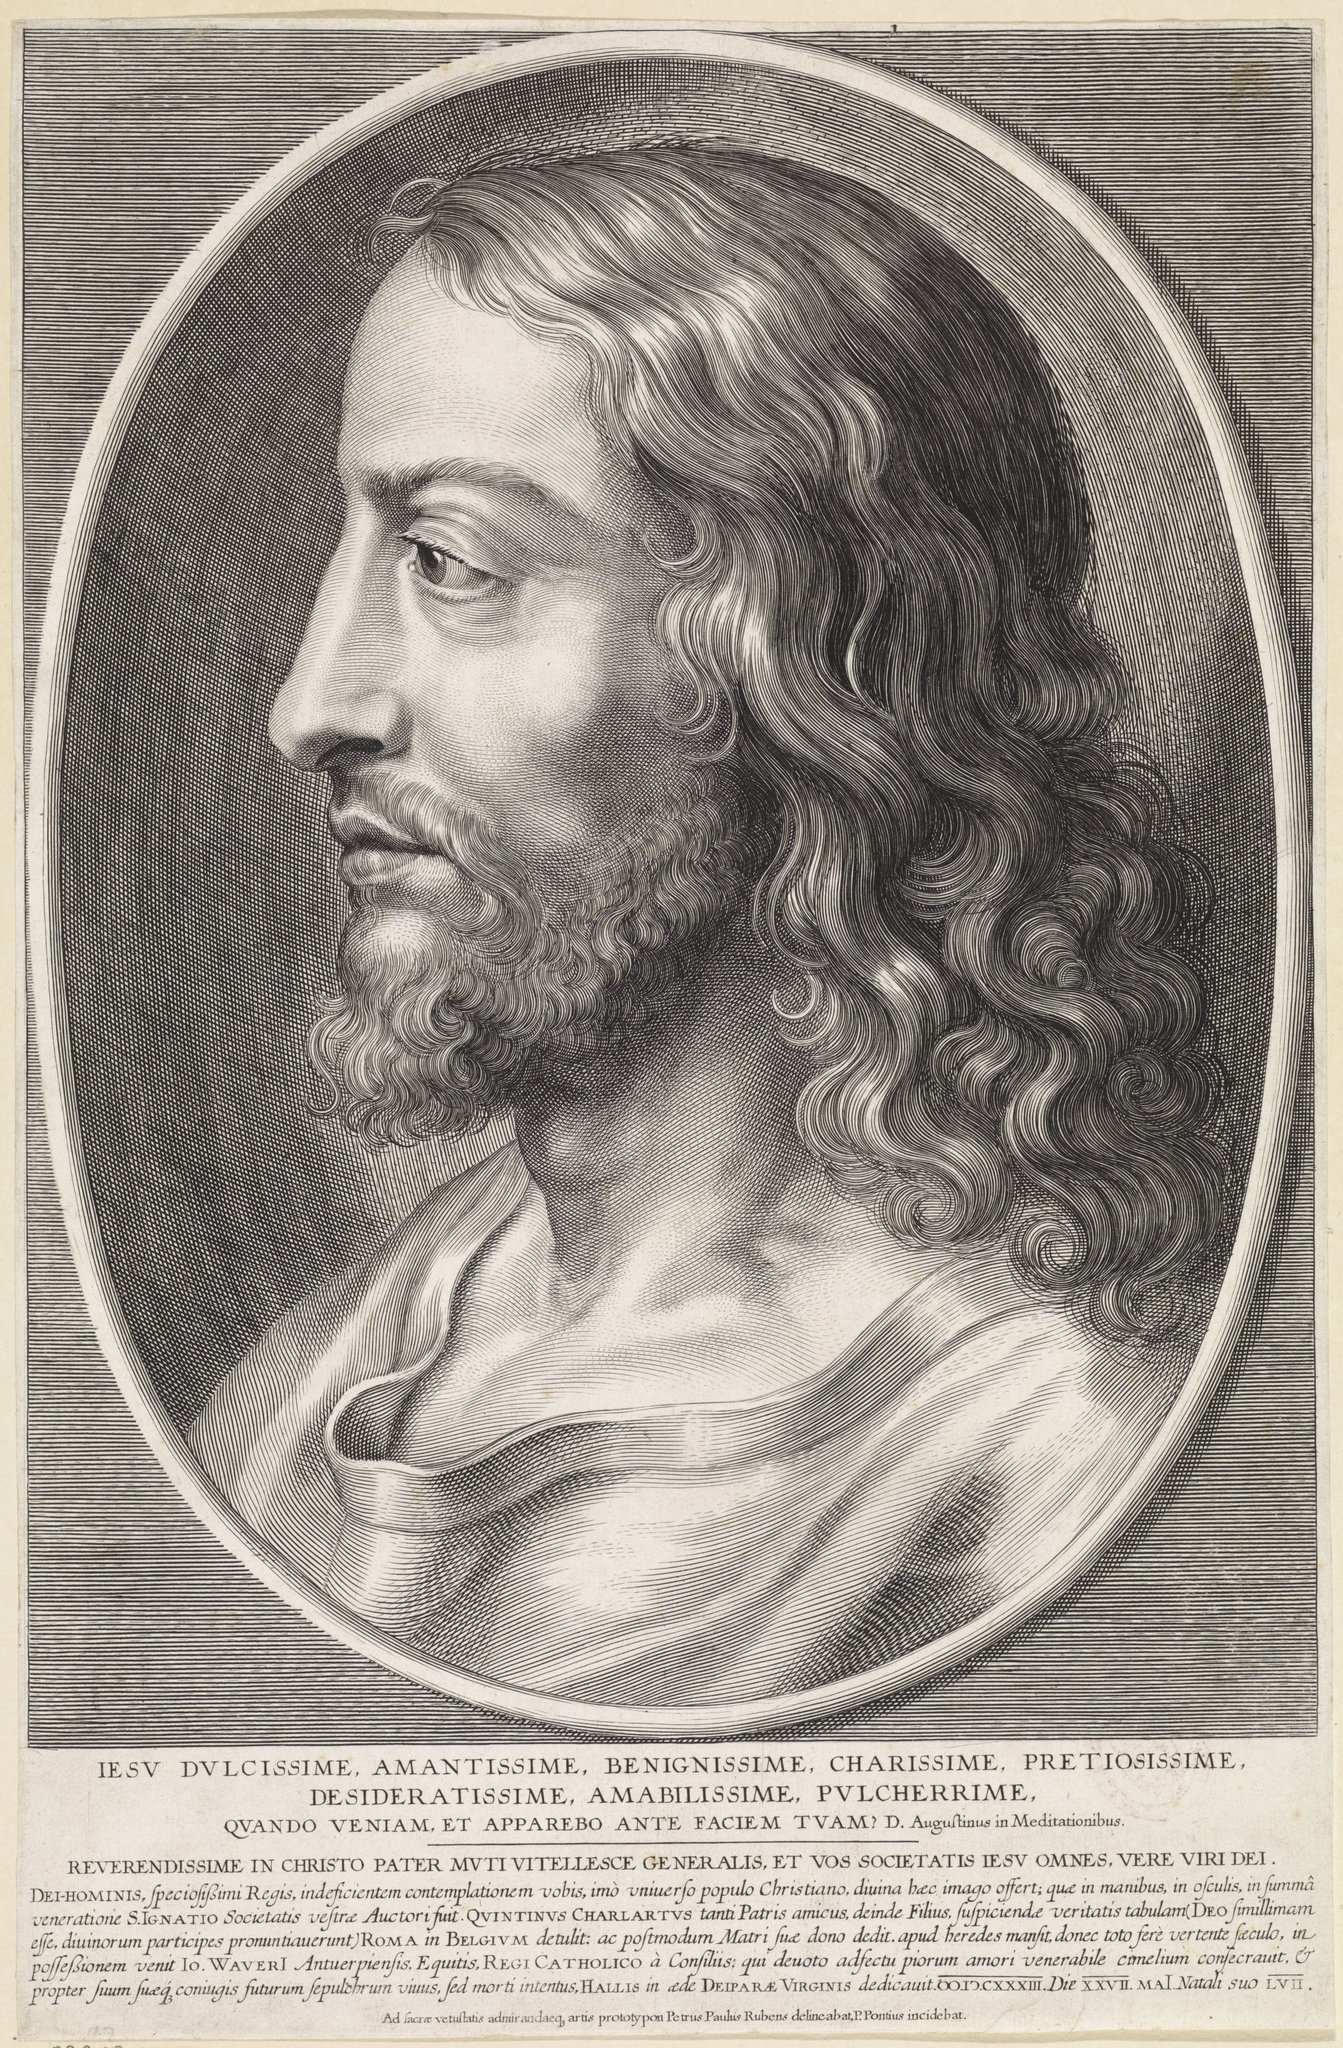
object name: print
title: Portret van Christus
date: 1633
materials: paper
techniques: engraving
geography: antwerp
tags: 'portraits' of christ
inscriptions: collector's mark: Lugt 240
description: Portret van Christus. In de marge een drieregelig onderschrift in het Latijn. Daaronder een zesregelig onderschrift met een opdracht in het Latijn.